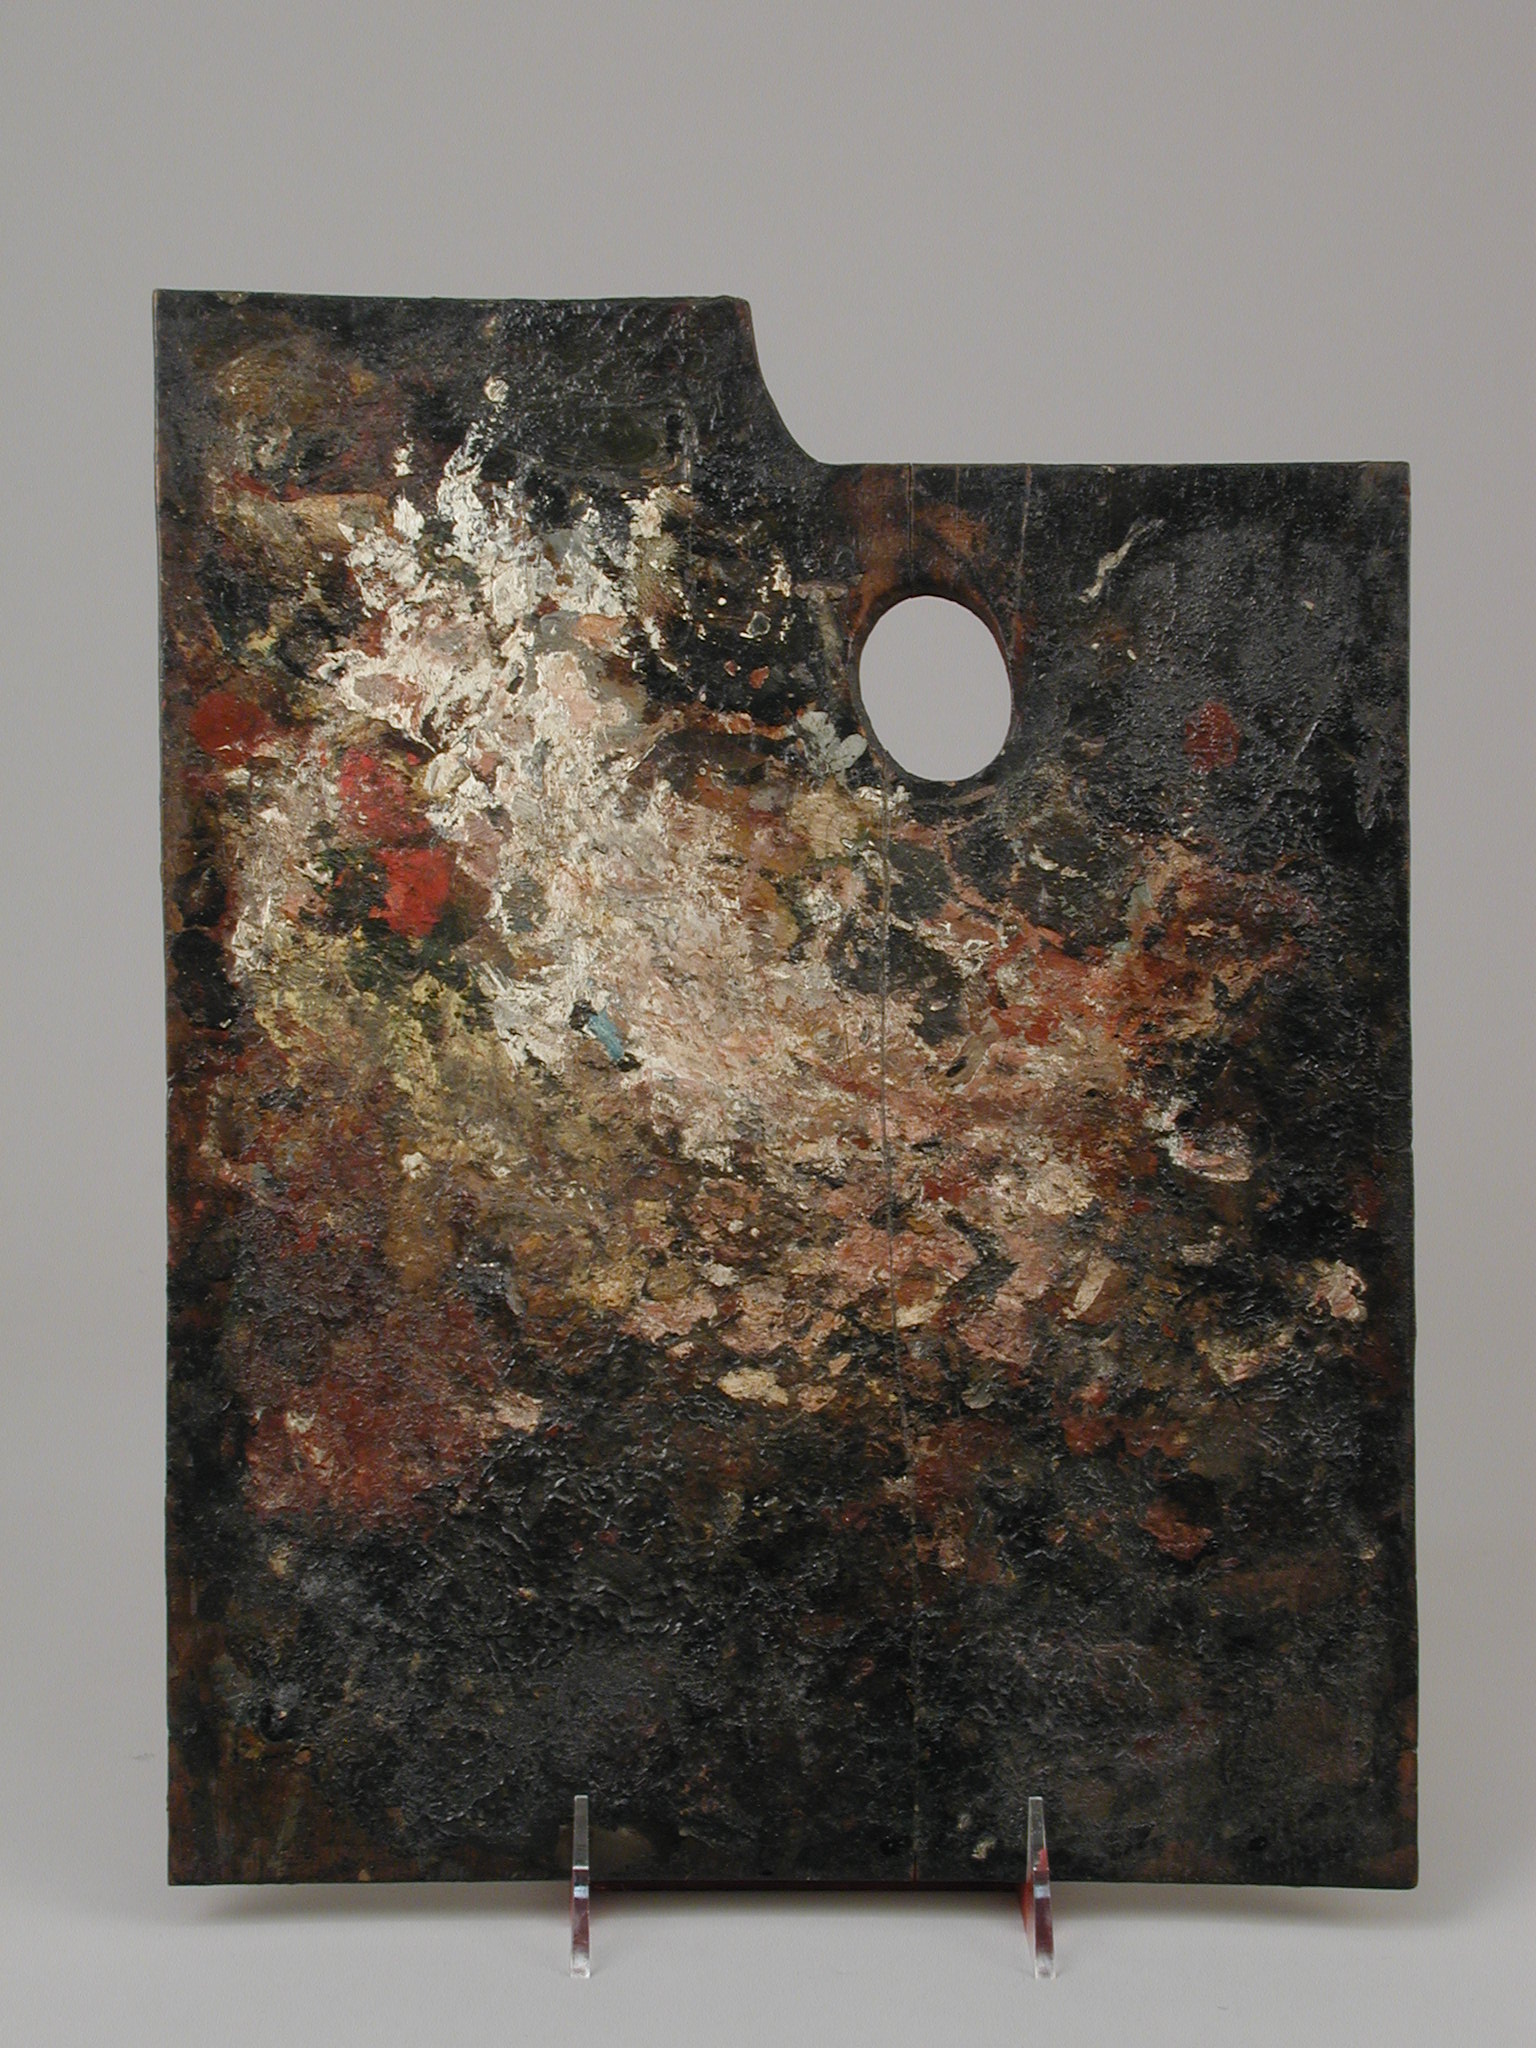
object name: palette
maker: honoré daumier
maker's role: artist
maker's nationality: french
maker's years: 1808-1879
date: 1801-1900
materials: oil, wood